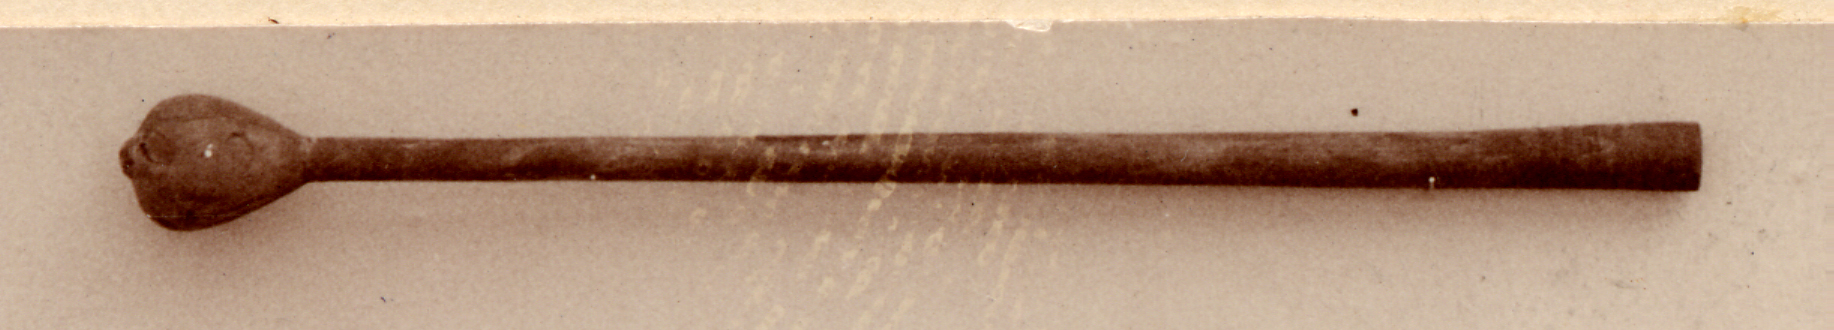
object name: model mace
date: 1981-1802 BCE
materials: wood